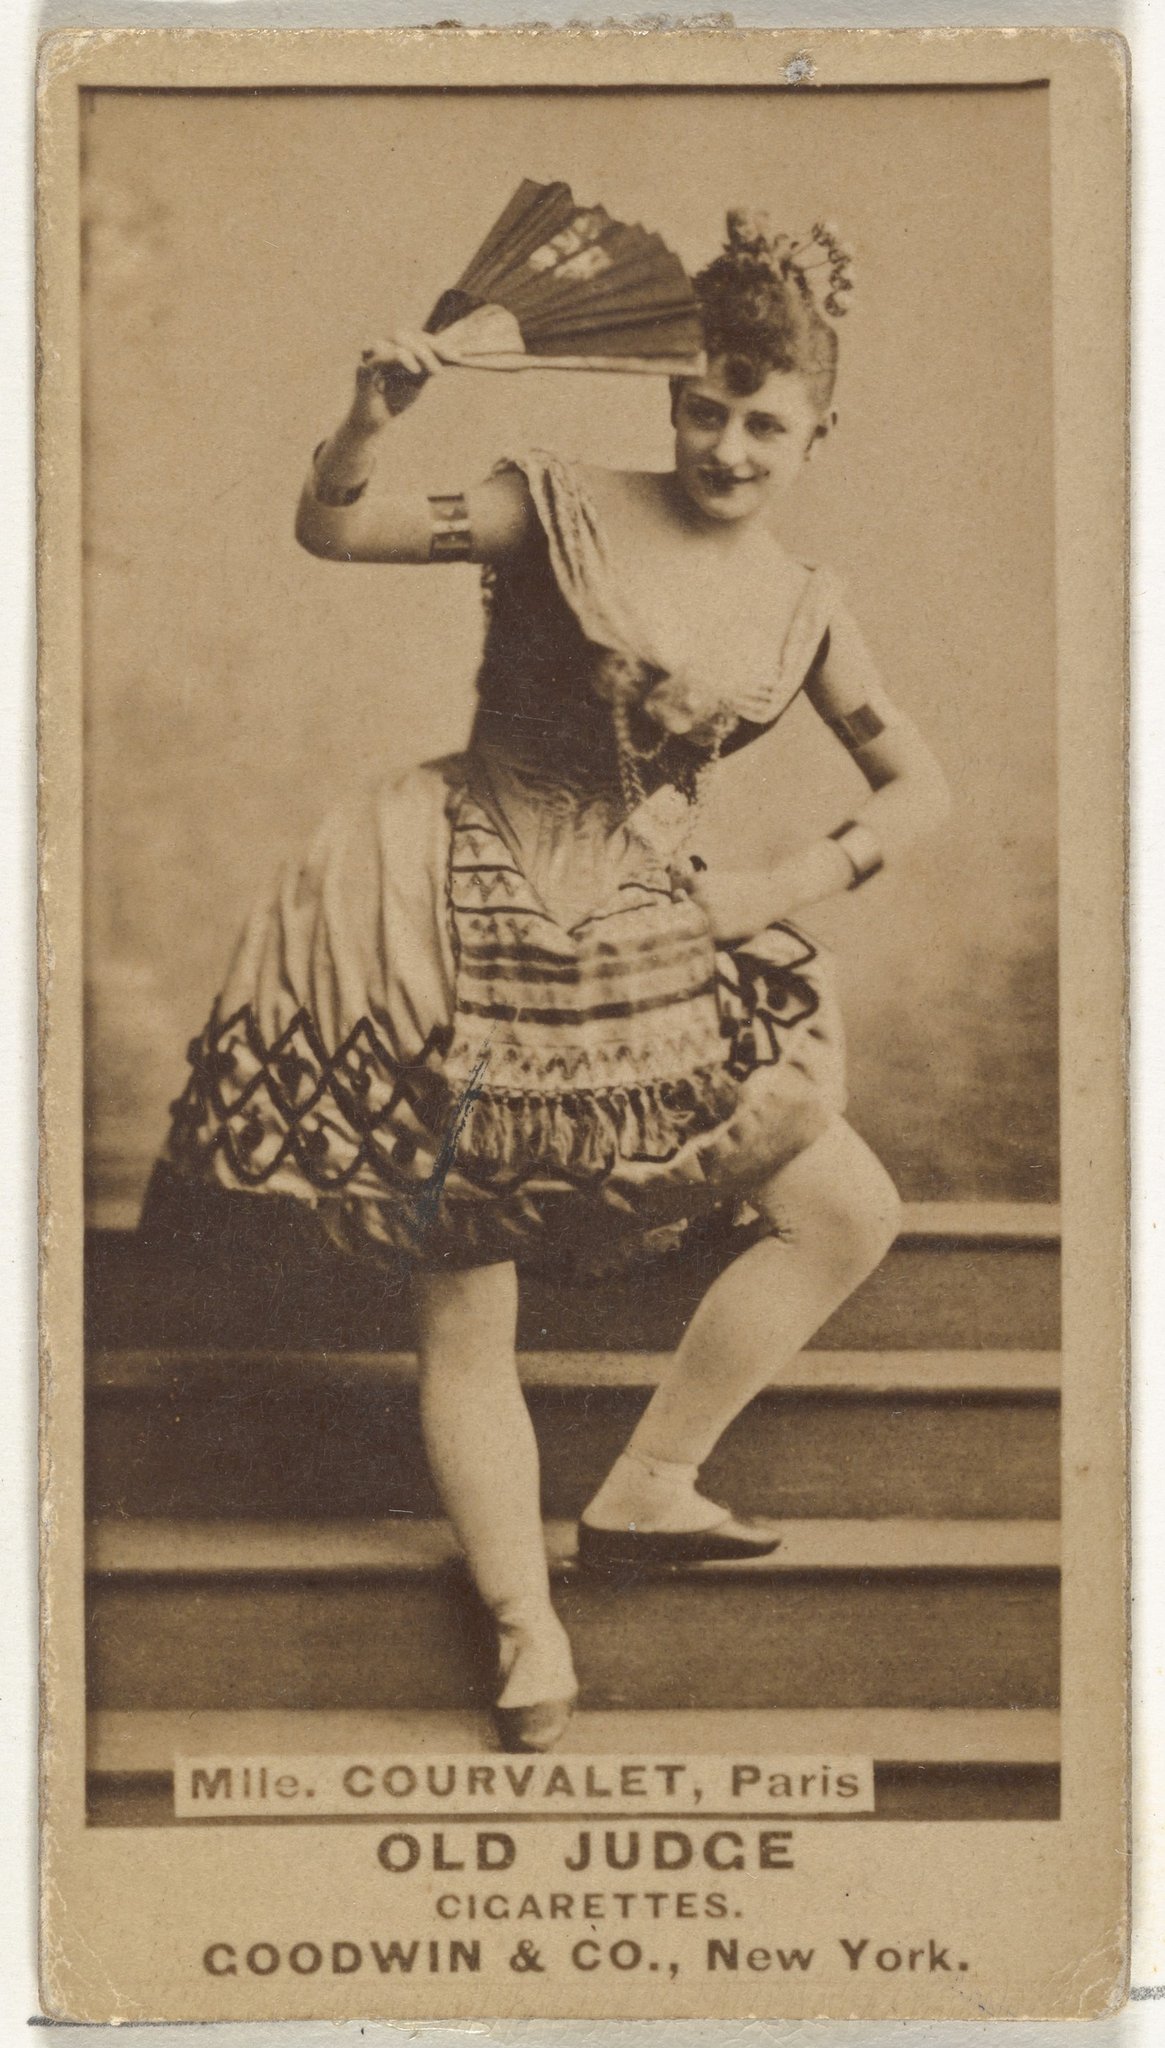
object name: photograph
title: Mlle. Courvalet, Paris, from the Actors and Actresses series (N171) for Old Judge Cigarettes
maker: goodwin & company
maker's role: publisher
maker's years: 1850-1950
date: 1886-1890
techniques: albumen silver print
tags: portraits,women,actresses